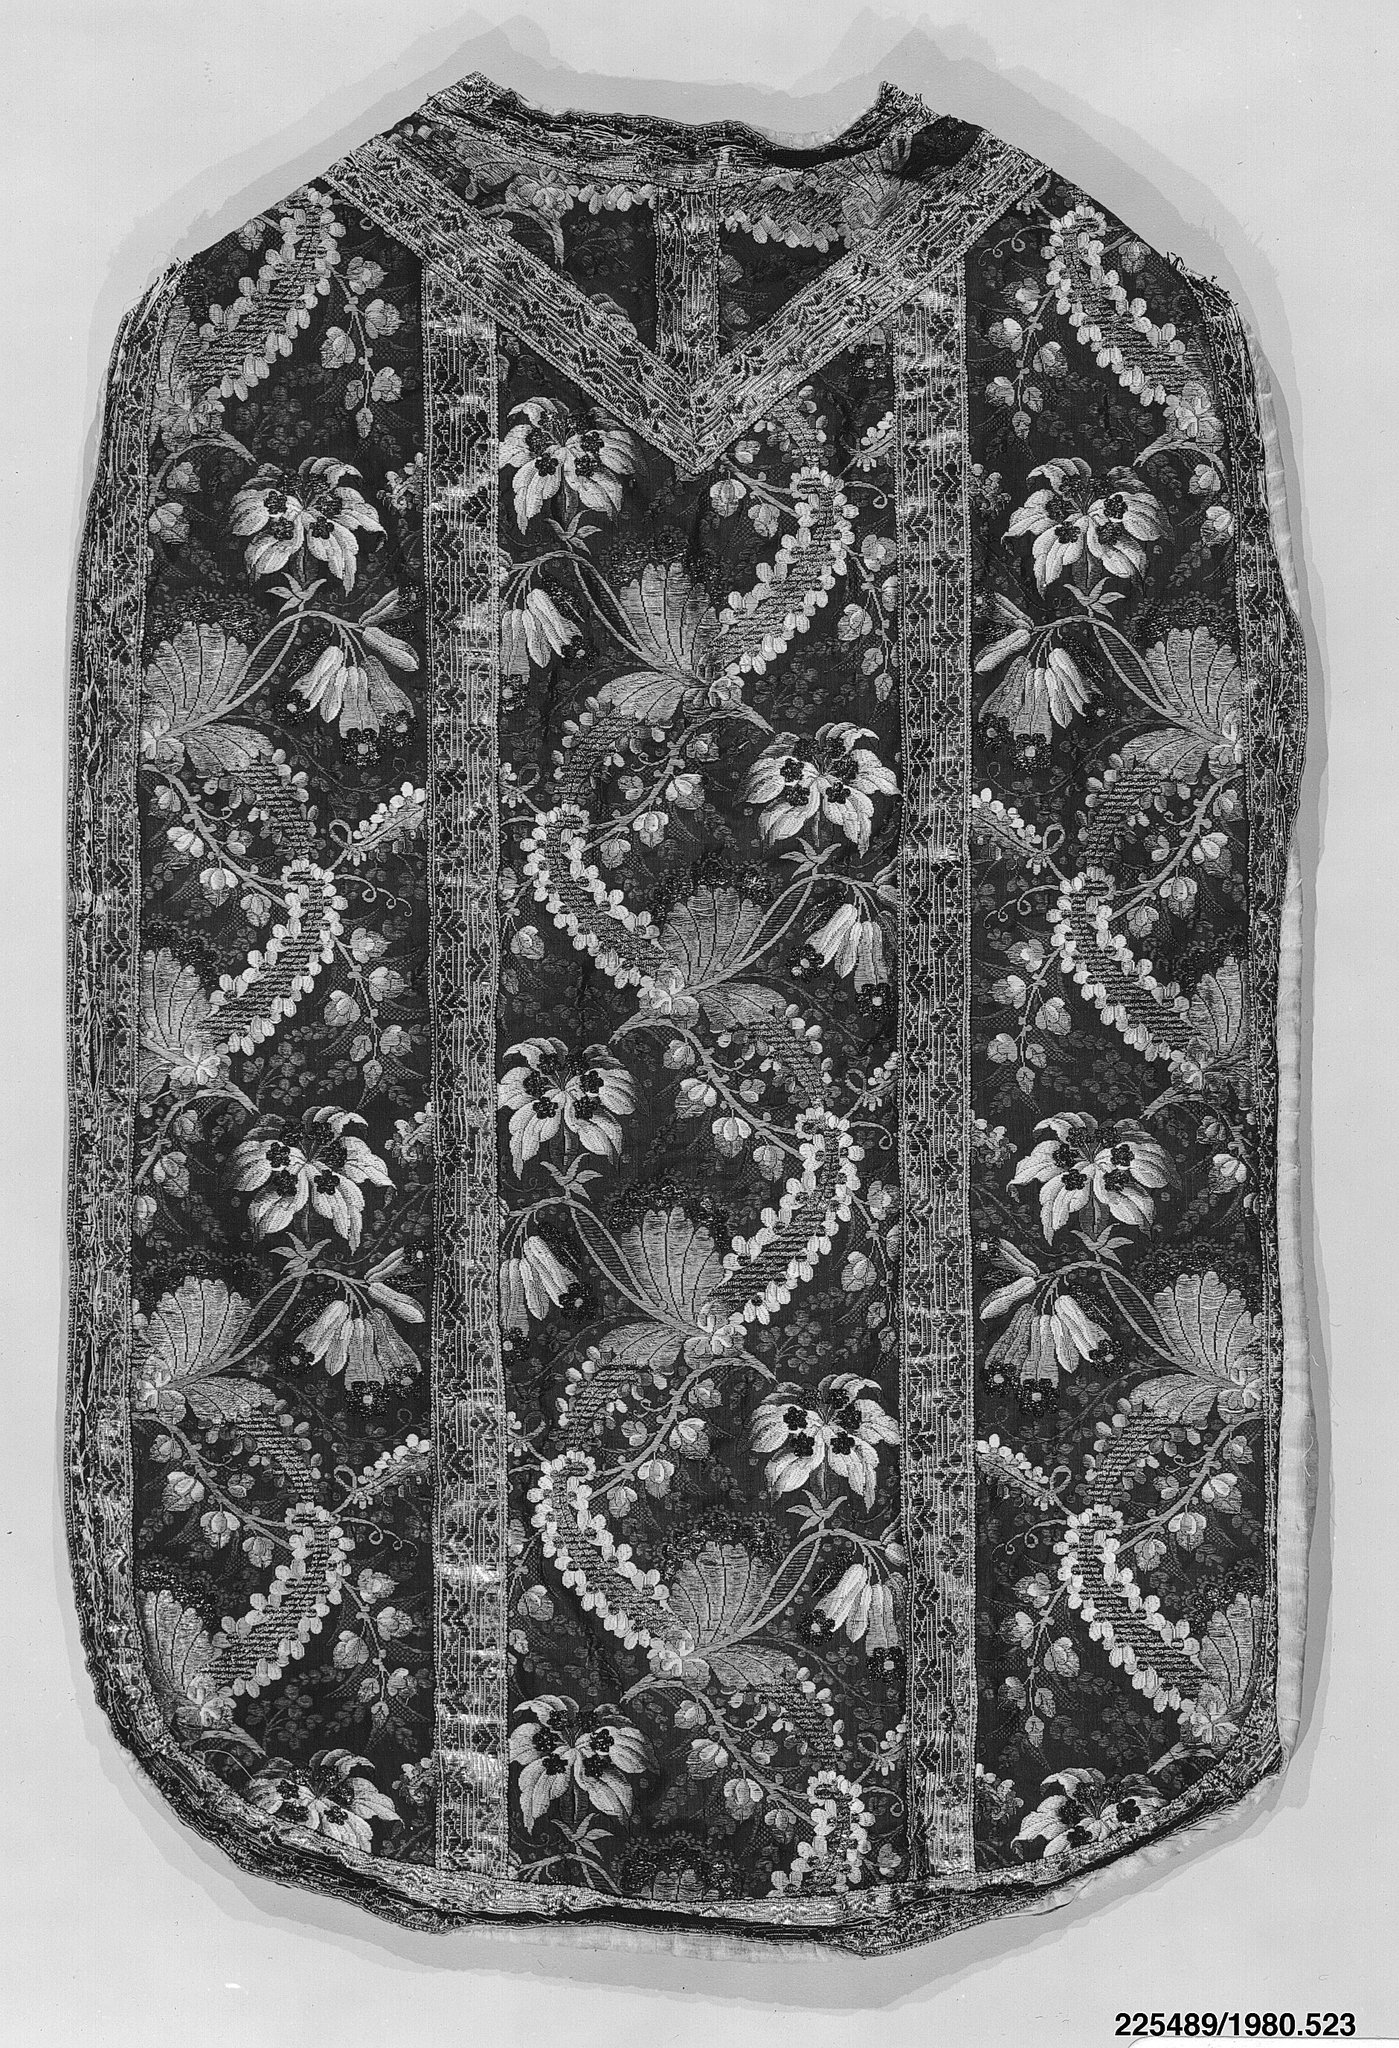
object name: chasuble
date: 1801-1900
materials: gilt, metal, silk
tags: flowers,leaves